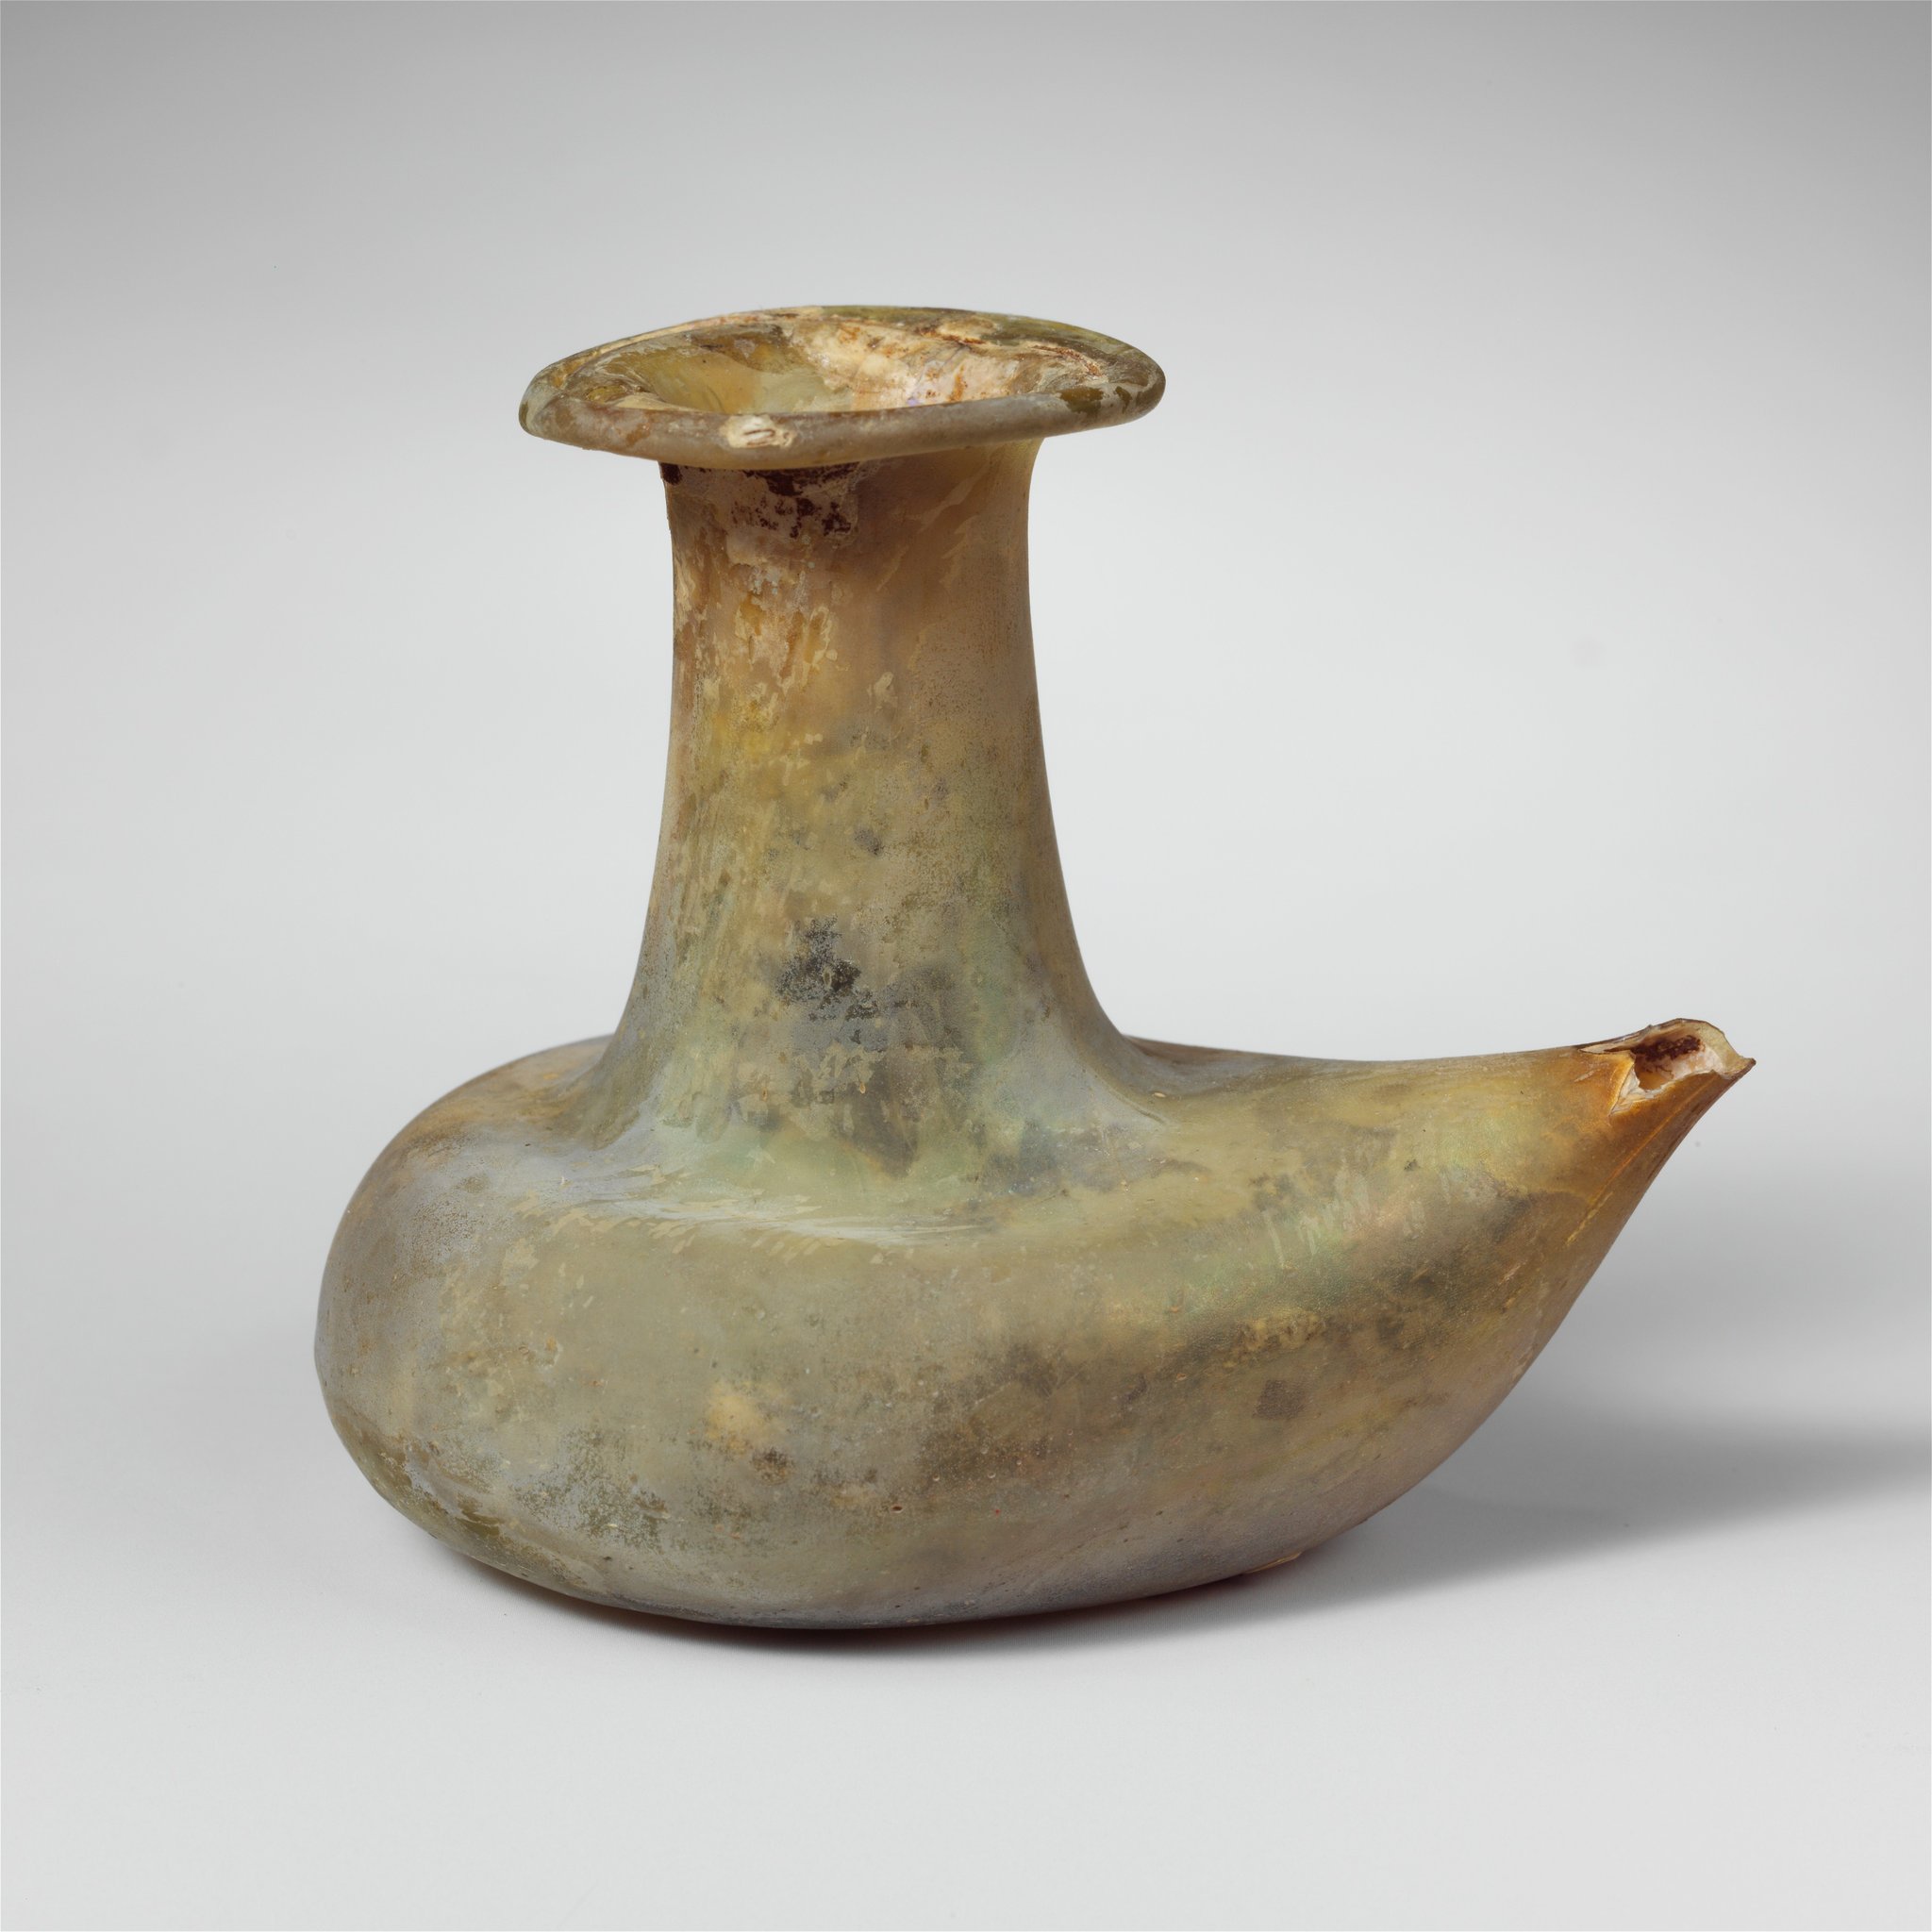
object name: pourer flask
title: Glass pourer flask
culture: roman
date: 101-233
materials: glass